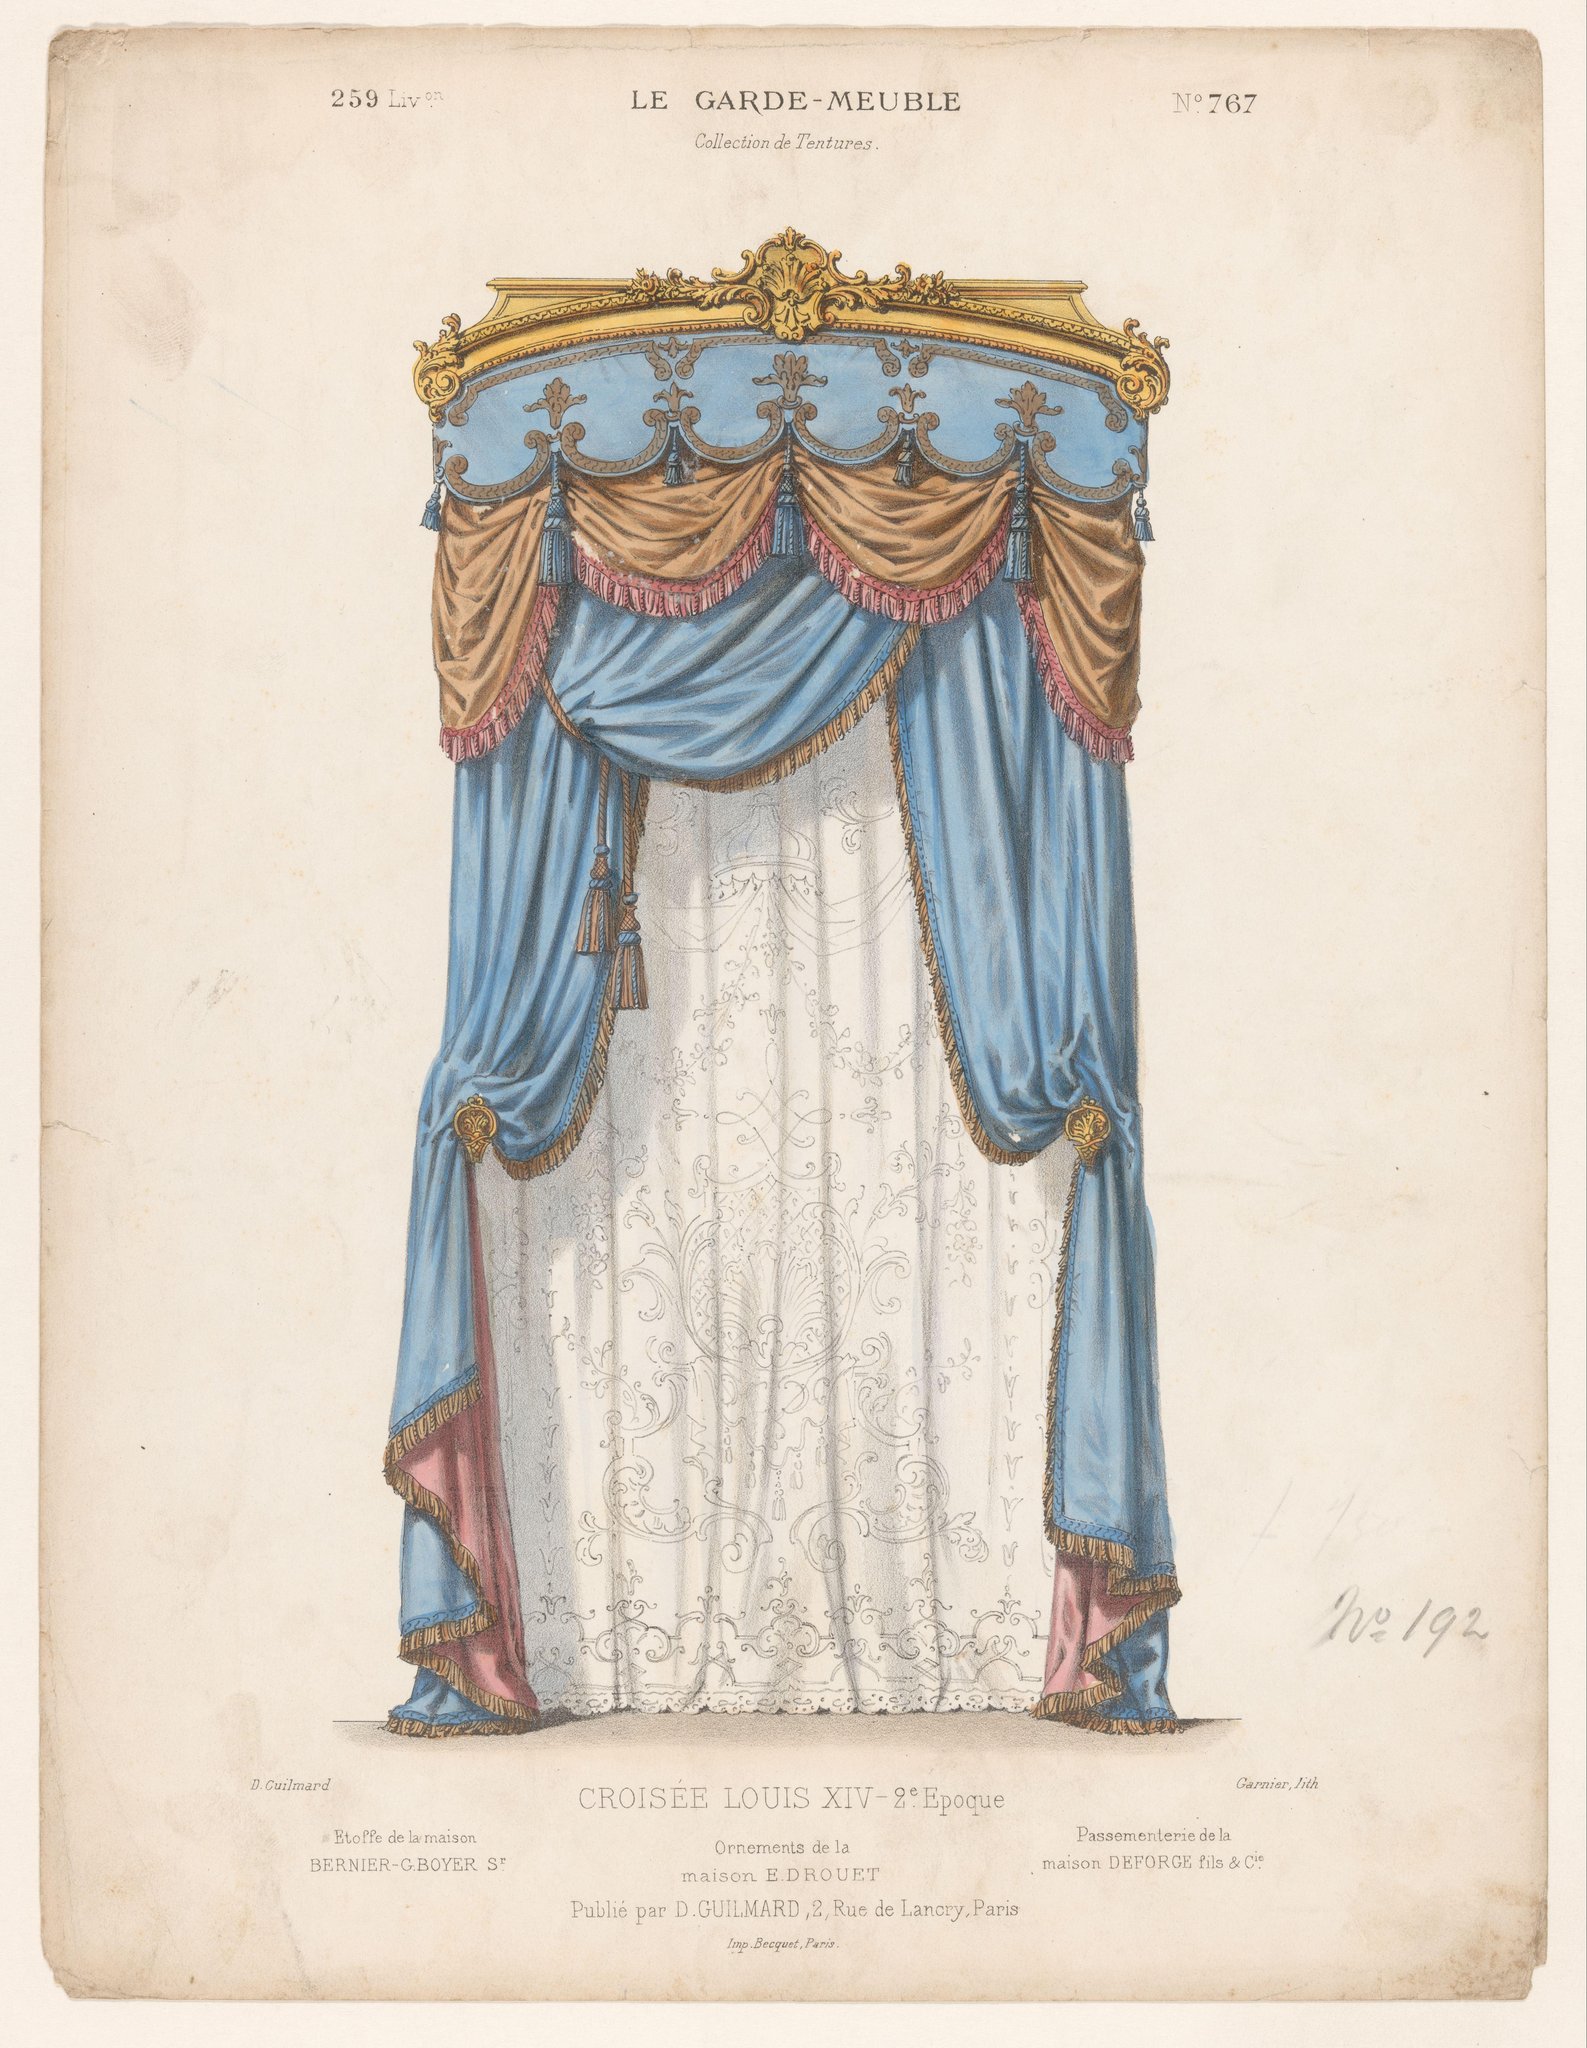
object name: print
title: Venster met gordijnen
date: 1860-1880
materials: paper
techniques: hand coloring, lithograph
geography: paris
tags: window, hangings and drapery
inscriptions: number: ‘no 192’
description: Kruisvenster met gedrapeerde gordijnen in de Lodewijk XIV-stijl. Prent uit 259e Livraison.